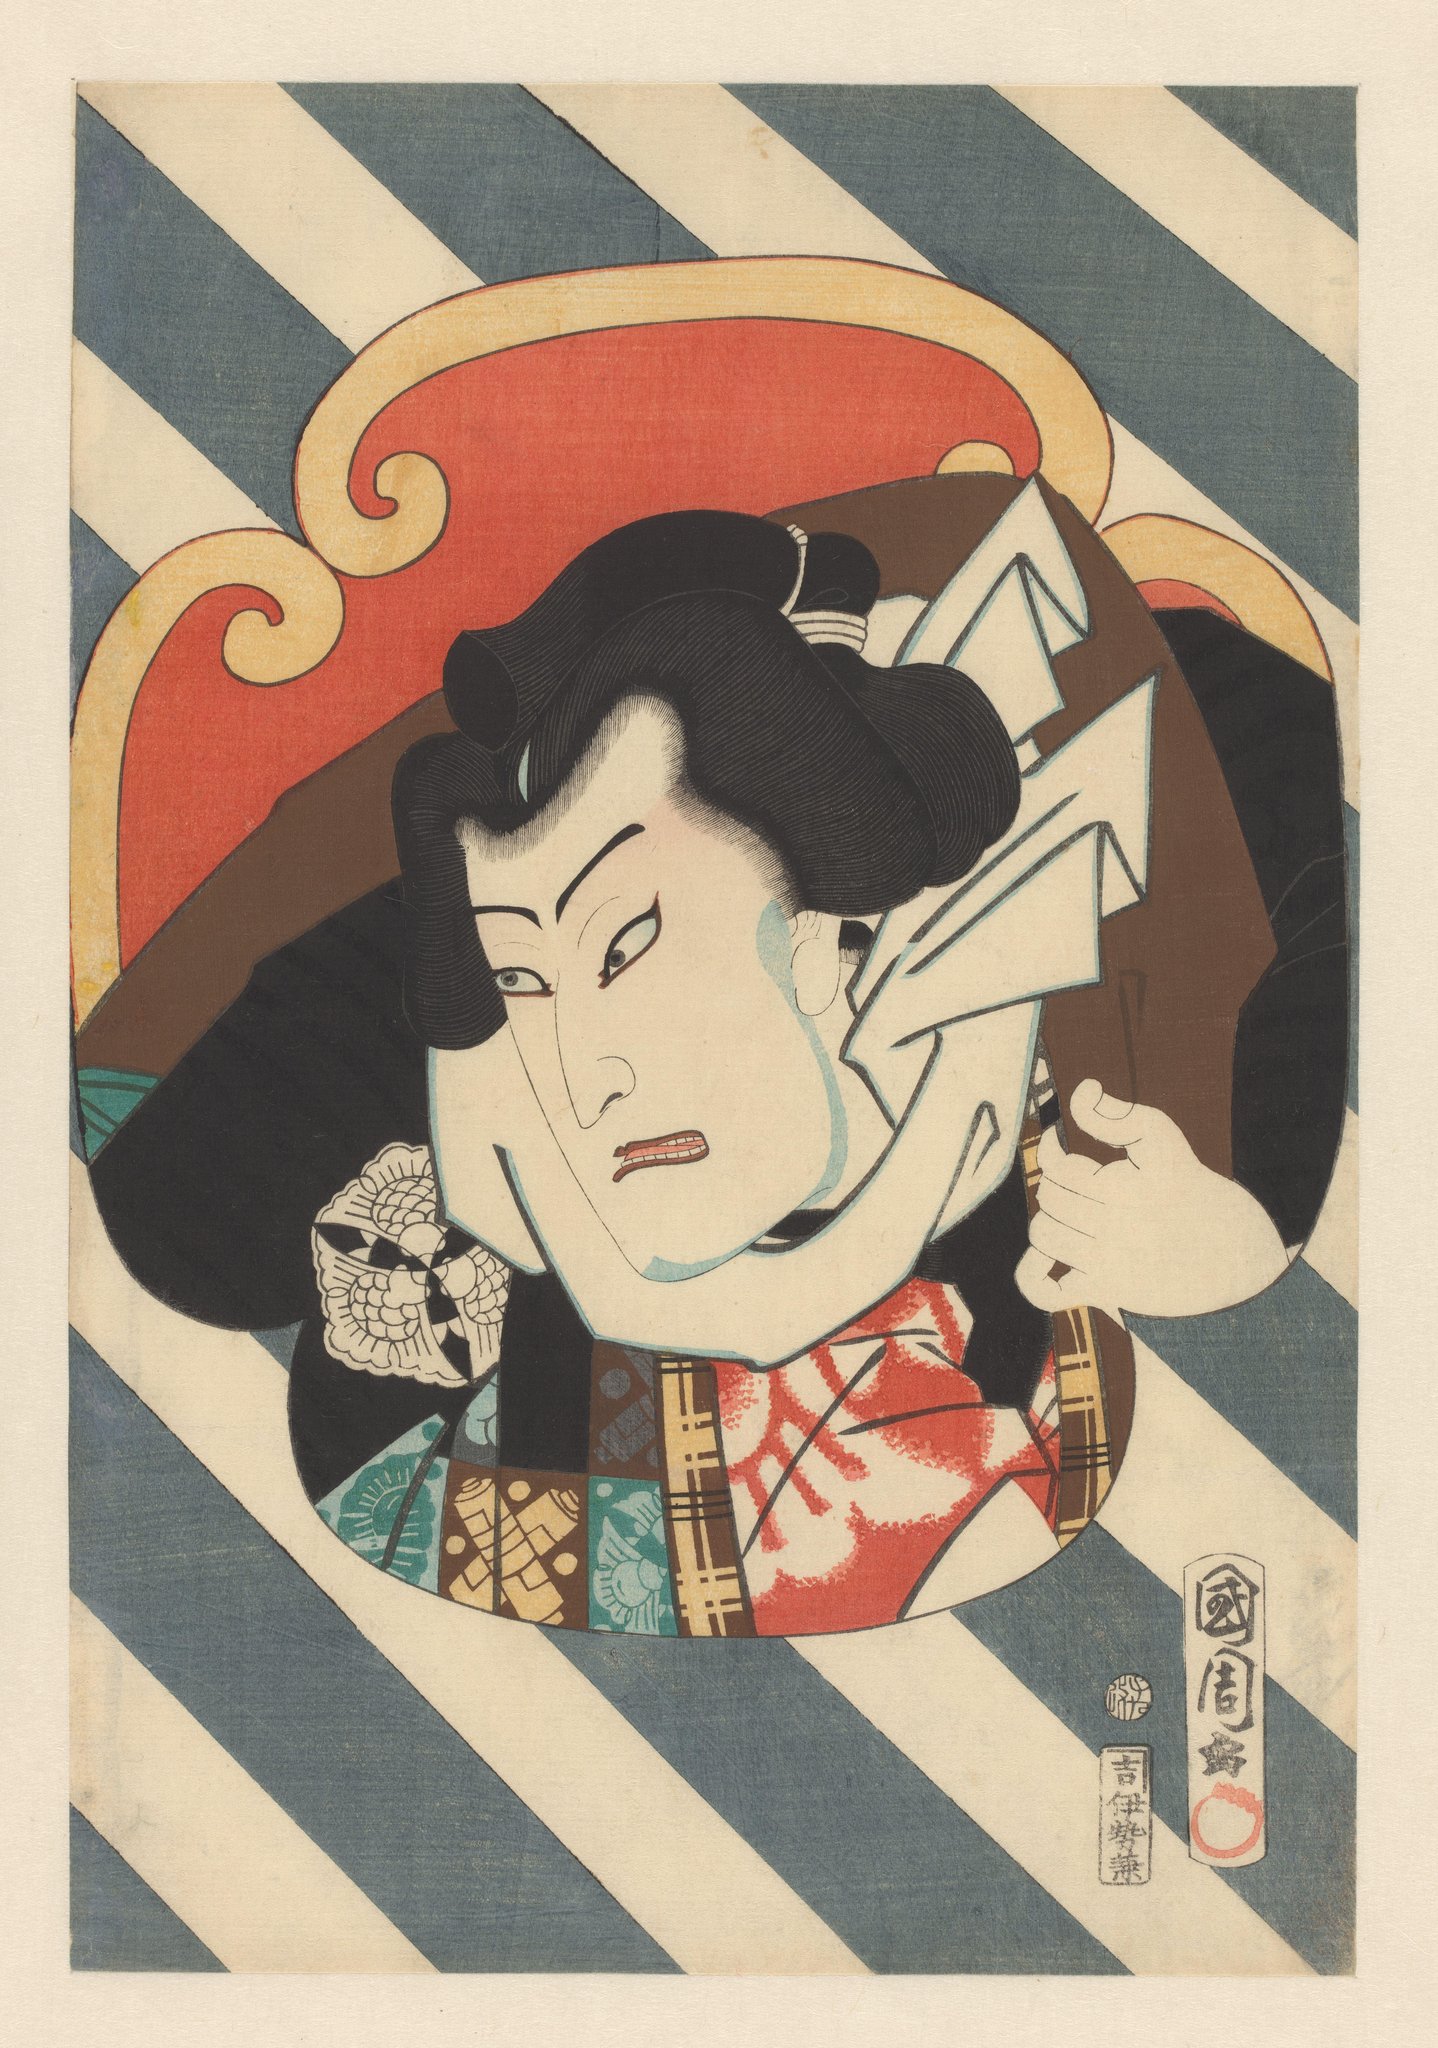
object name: print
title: Portrait of sumo wrestler Nuregami Chôgorô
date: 1809-1864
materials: paper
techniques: woodcut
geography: japan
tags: portrait of actor, actress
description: Portret van kabuki acteur Nakamura Shikan IV in de rol van sumo worstelaar Nuregami Chôgorô, tegen een grijs-wit gestreepte achtergrond. Het portret is afgebeeld in een cartouche wat gevormd is uit vier (Japans: shi) ladegrepen (Japans: kan), verwijzend naar de naam van de afgebeelde acteur 'Shikan'.